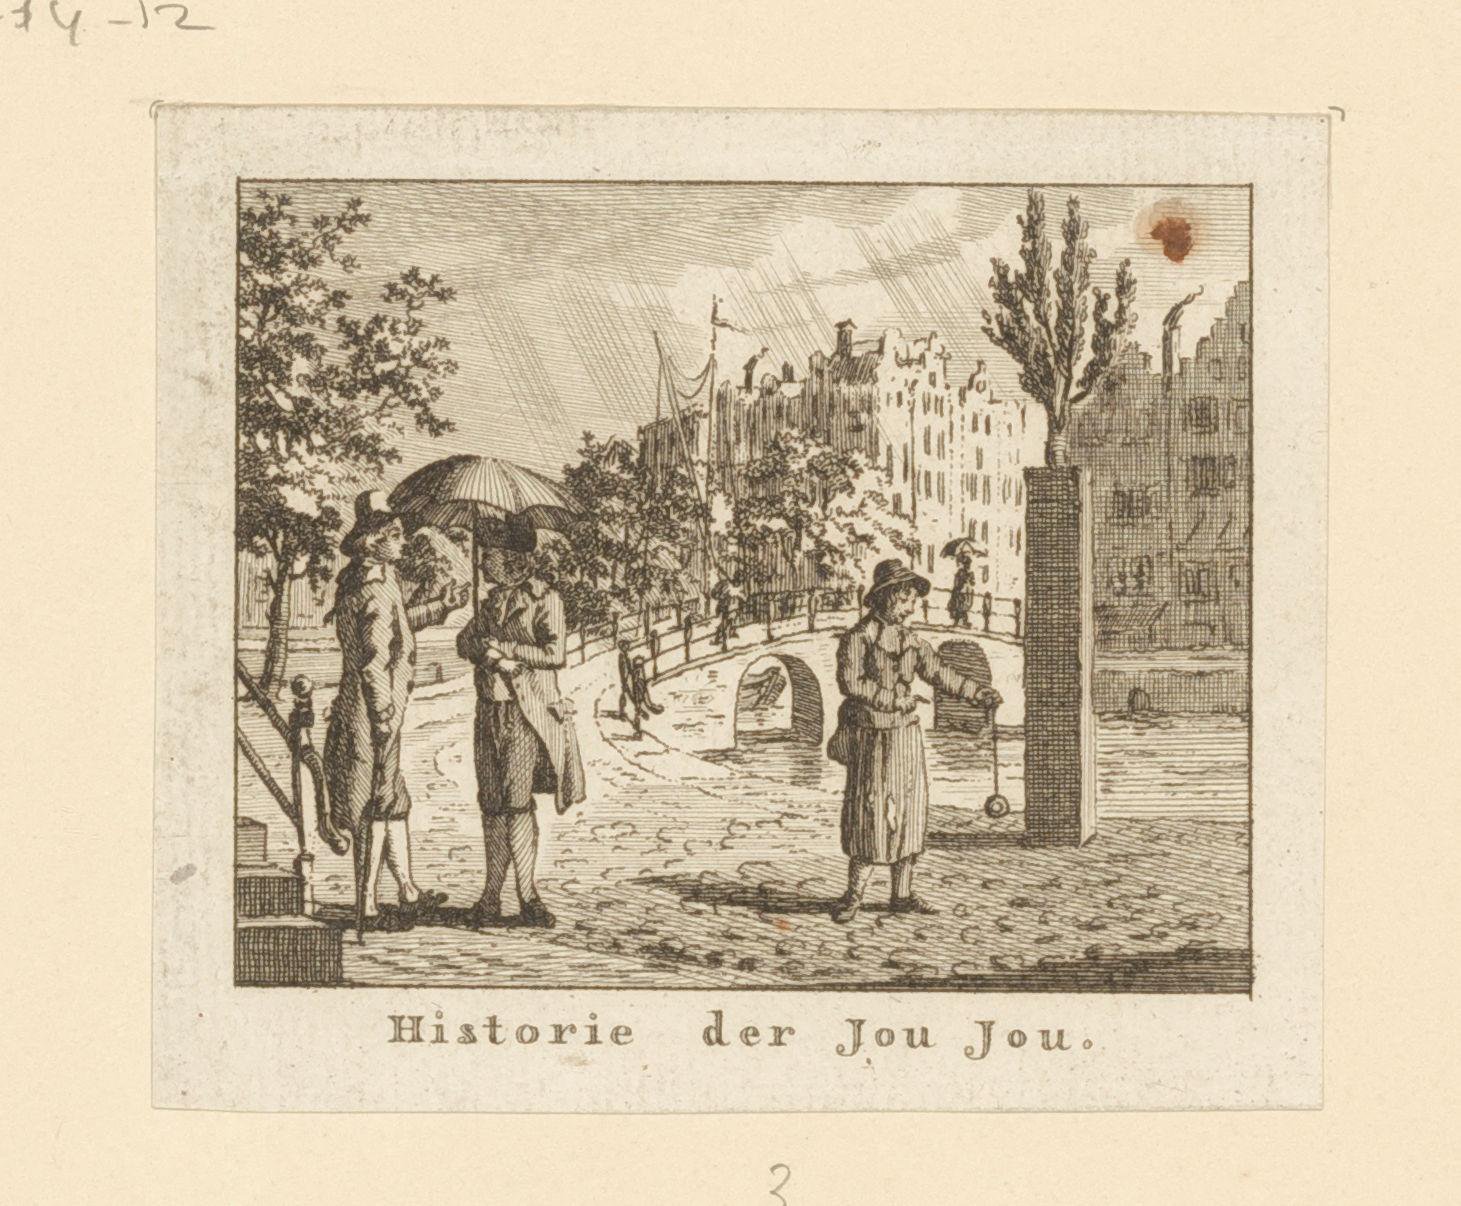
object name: print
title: Historie der Jou Jou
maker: Anonymous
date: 1790-1795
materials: paper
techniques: engraving, etching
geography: netherlands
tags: yoyo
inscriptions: collector's mark: Lugt 1641, collector's mark